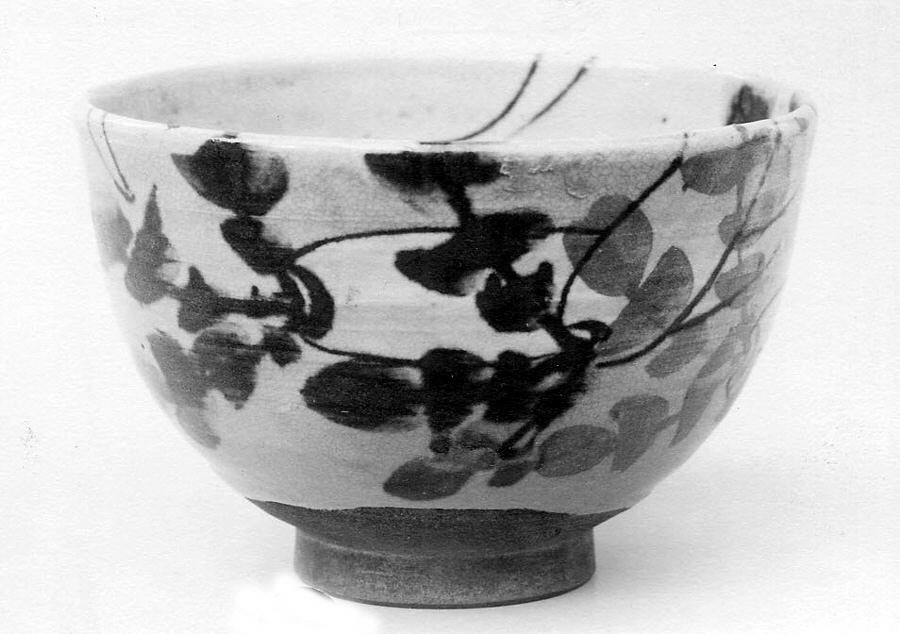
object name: teabowl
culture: japanese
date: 1825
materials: clay, glaze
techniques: molding